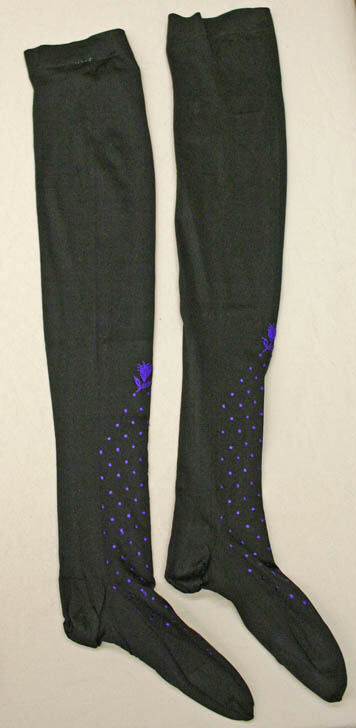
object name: stocking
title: Stockings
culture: french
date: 1865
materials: silk